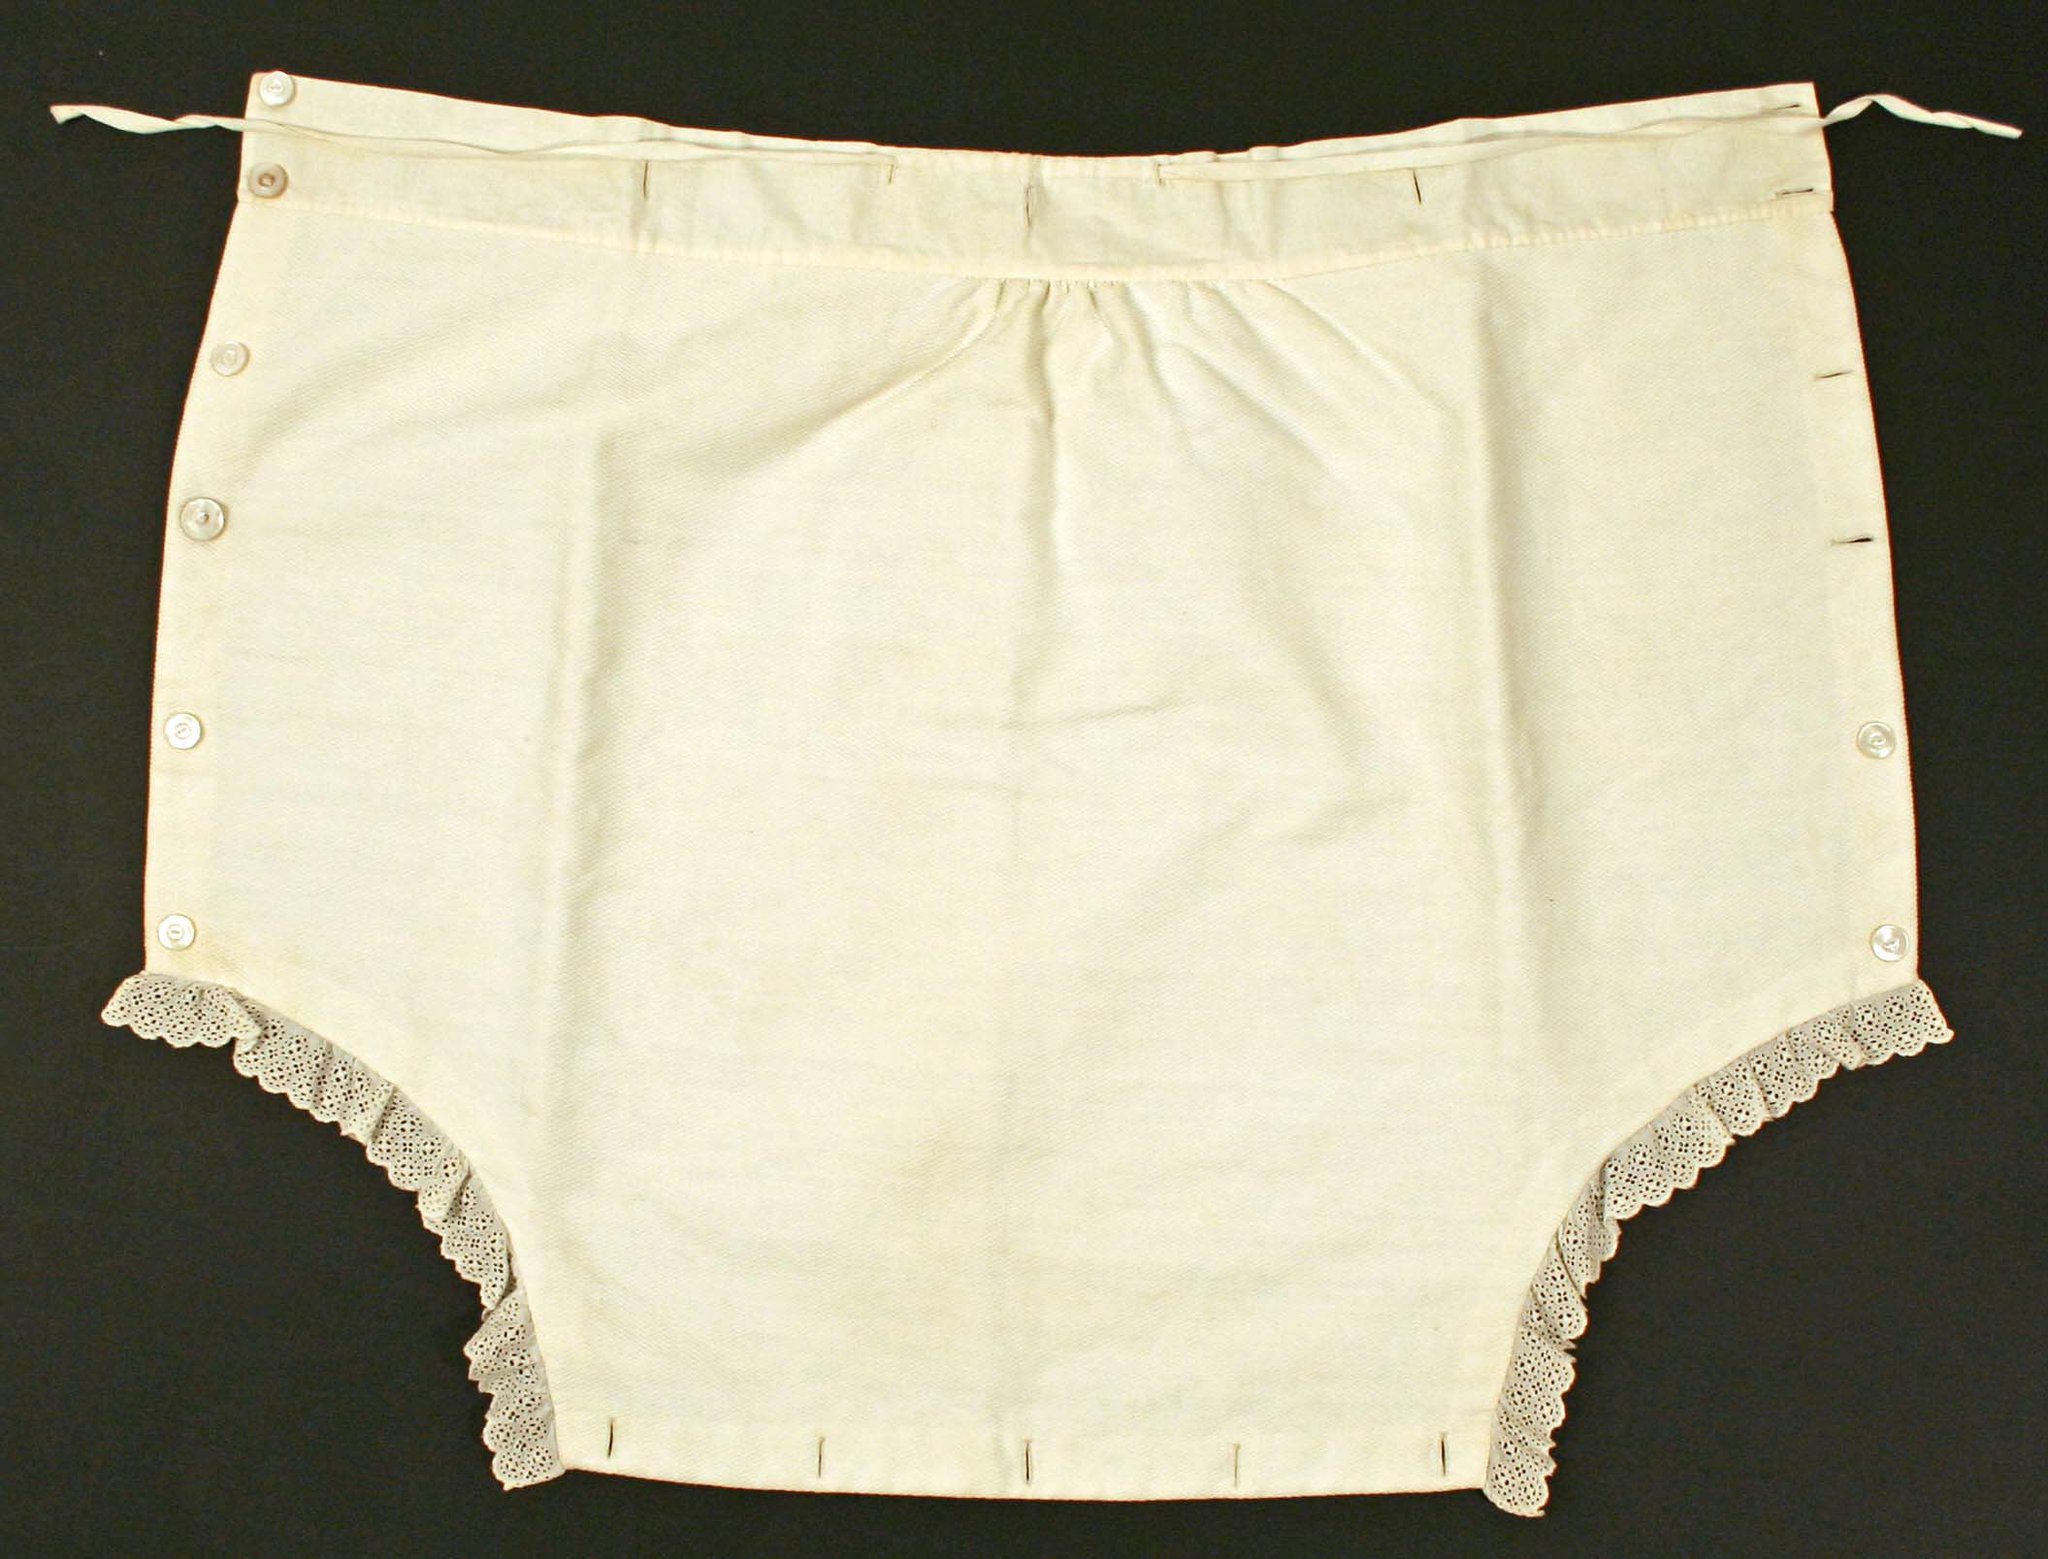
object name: drawer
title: Drawers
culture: american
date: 1887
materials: cotton, wool